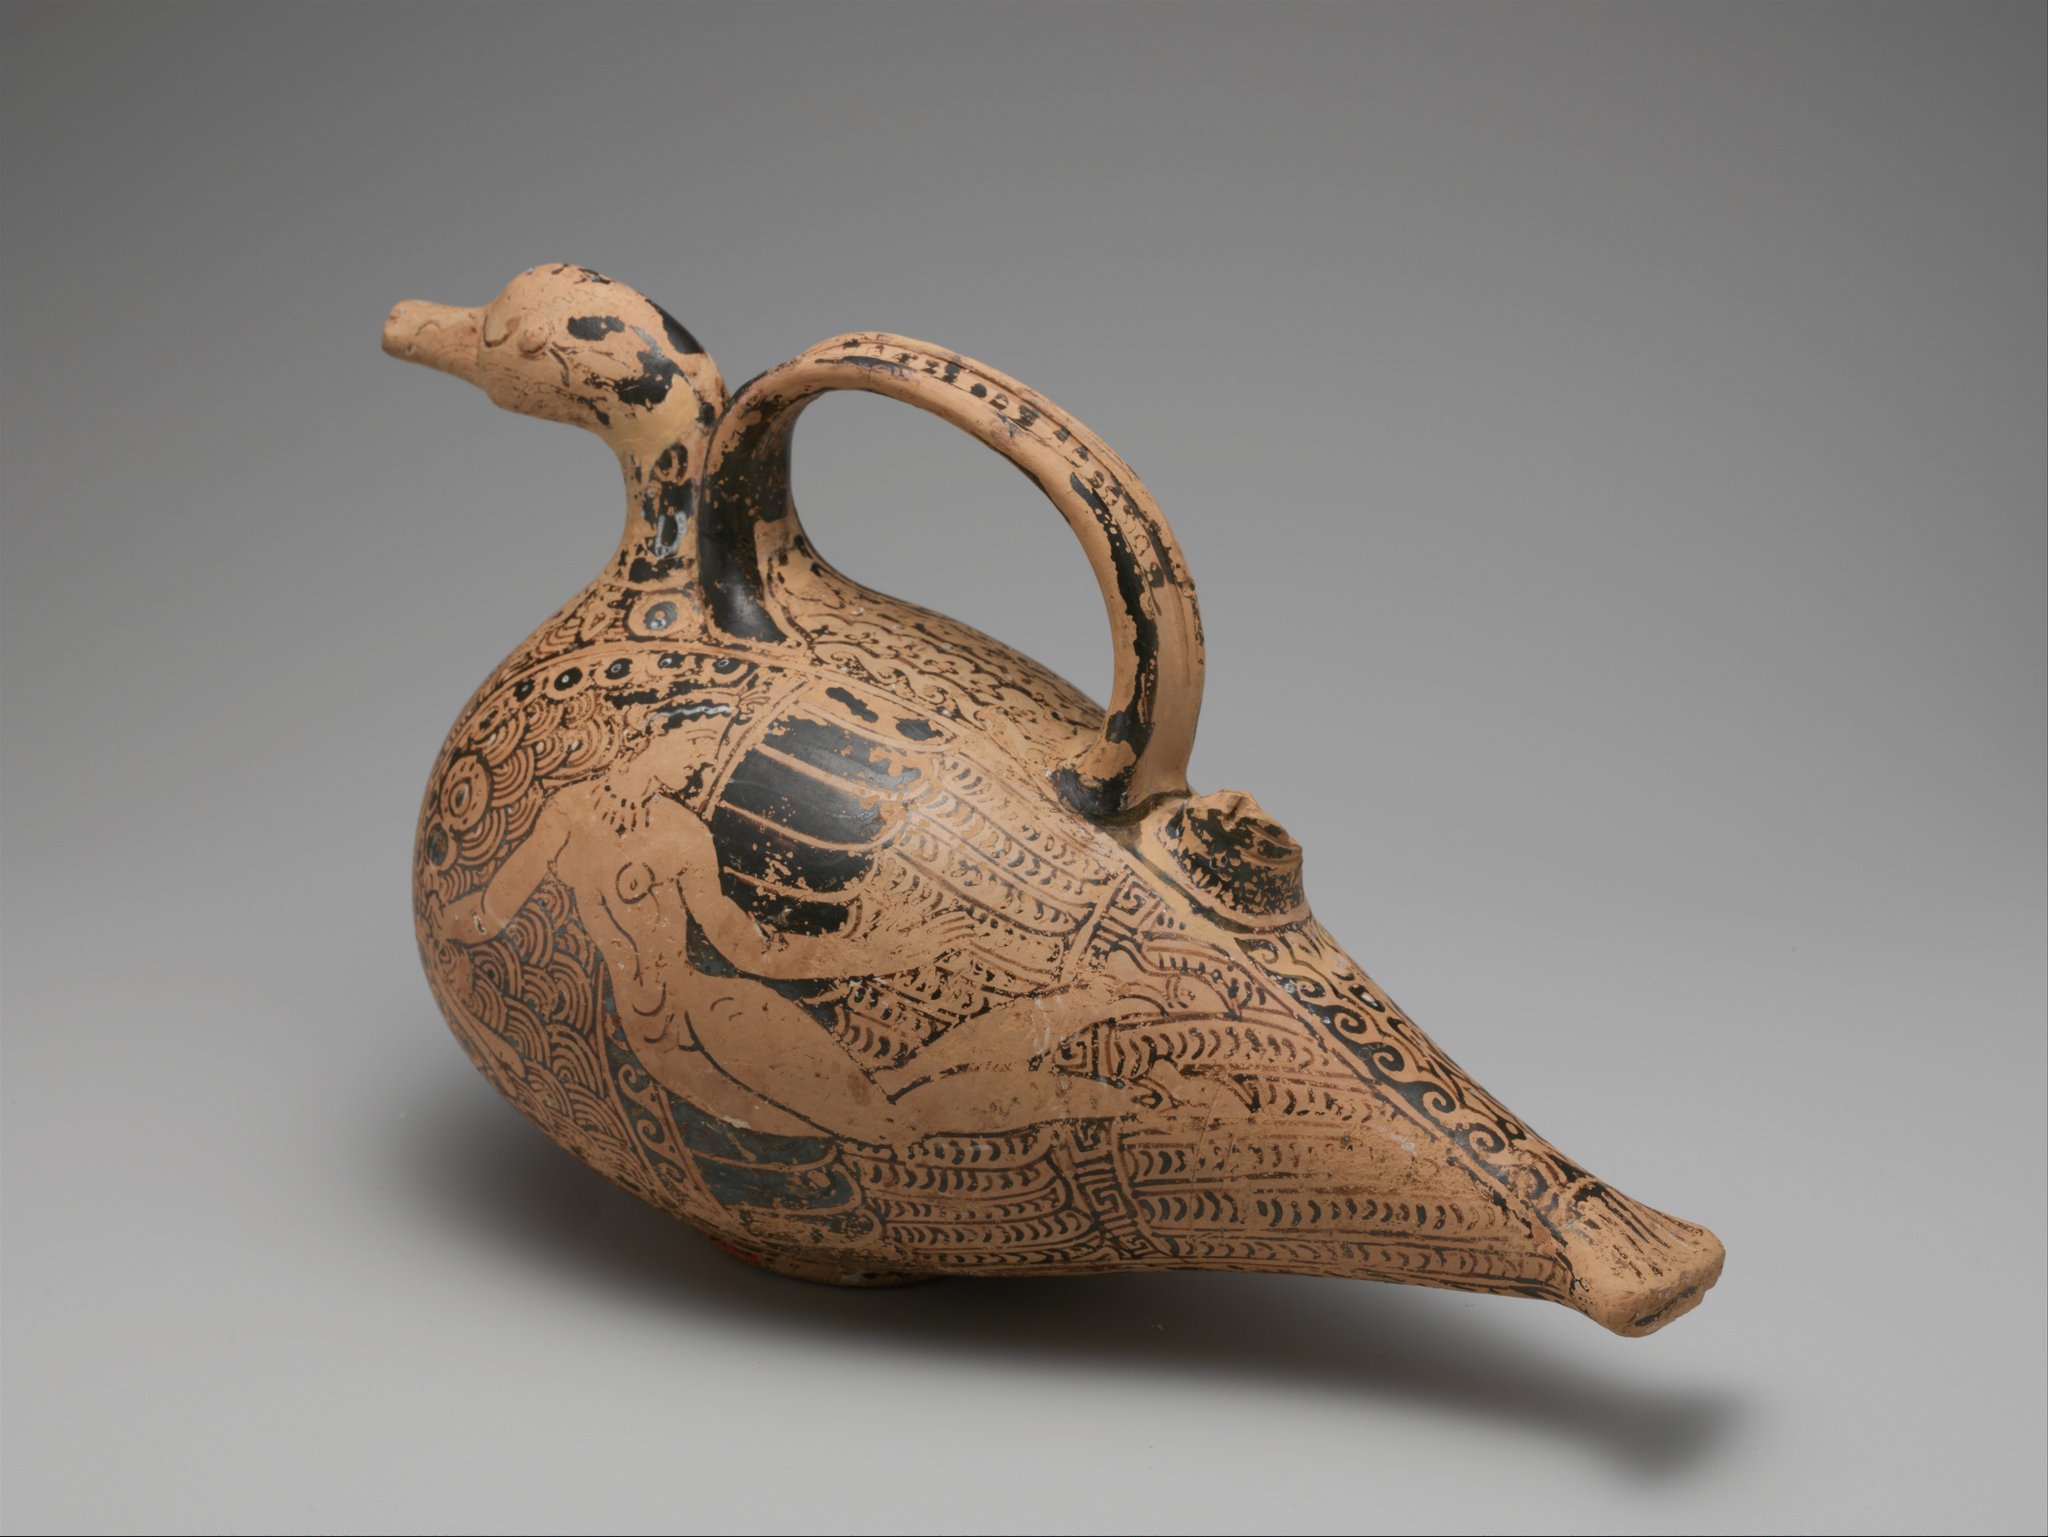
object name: askos in the form of a duck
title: Terracotta duck-askos (flask with spout and handle)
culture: etruscan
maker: clusium group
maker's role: artist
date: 350-325 BCE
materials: terracotta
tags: ducks,female nudes